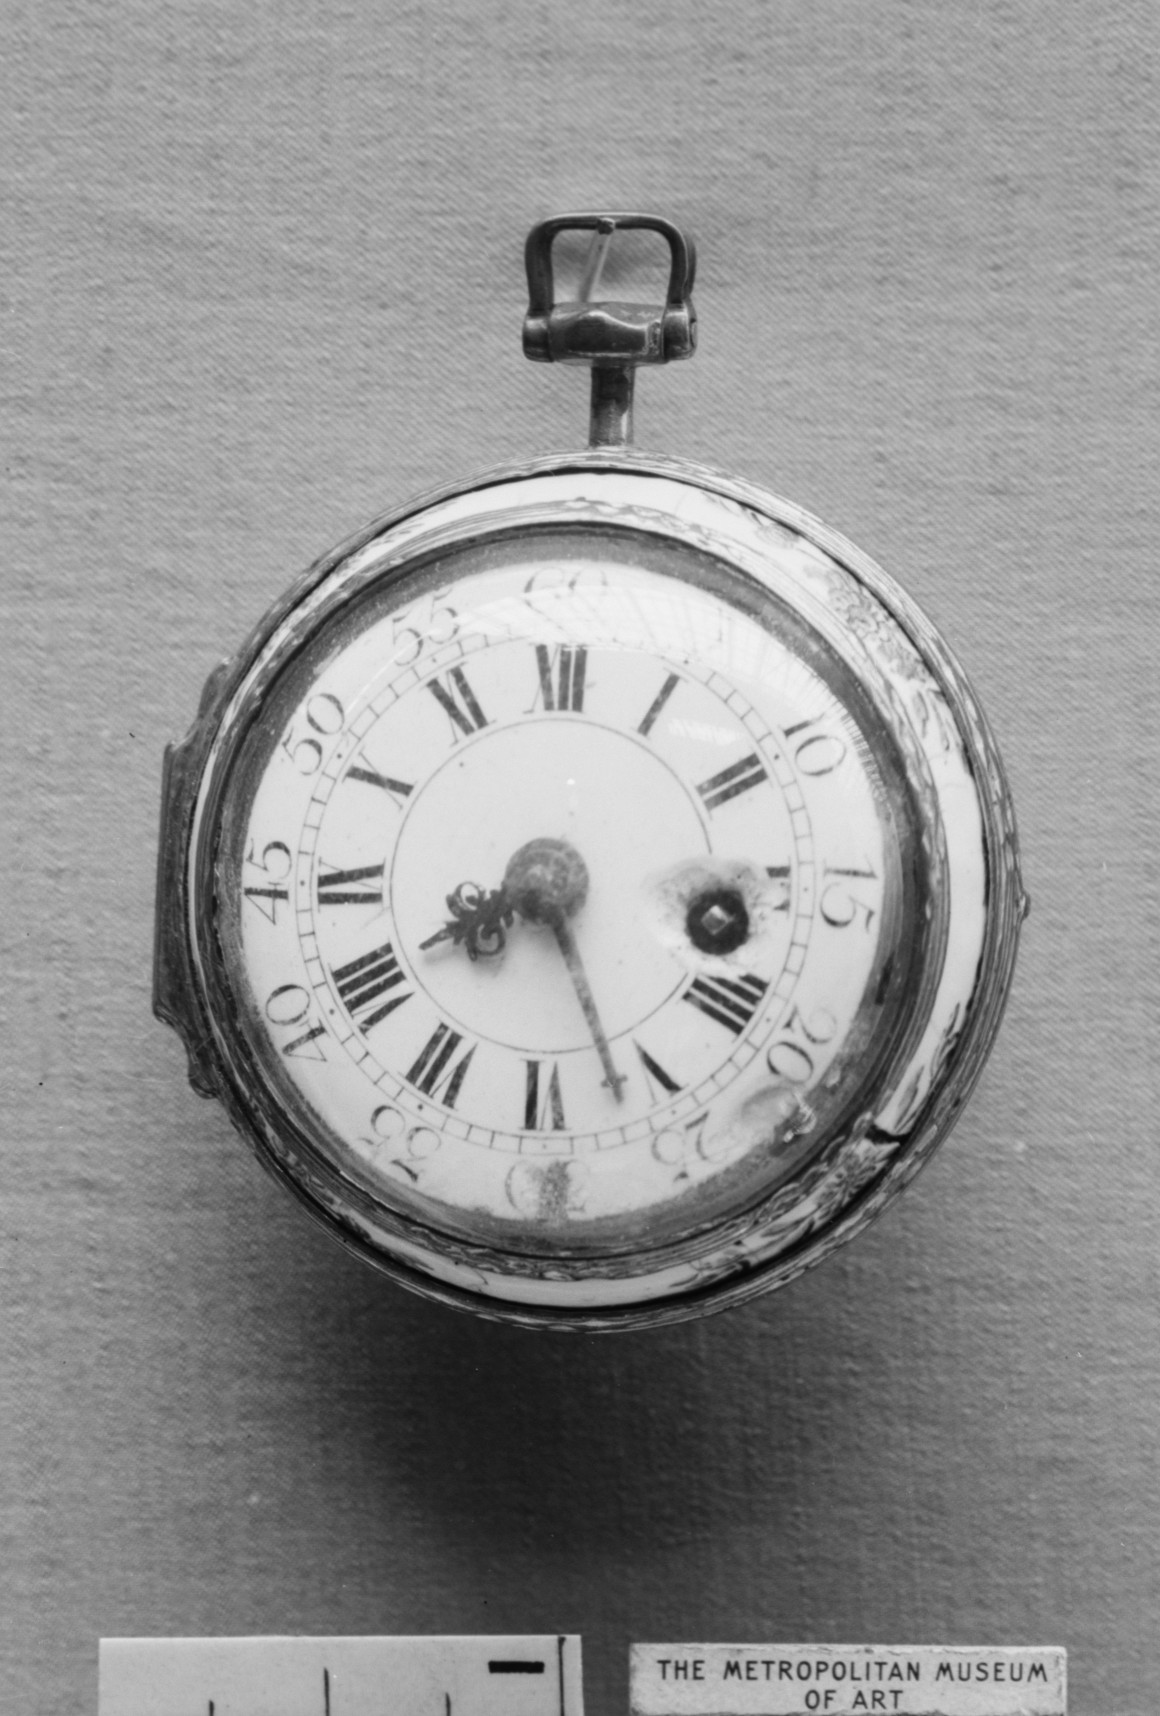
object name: watch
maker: julien le roy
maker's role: maker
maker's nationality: french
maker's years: 1686-1759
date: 1701-1800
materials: copper, enamel, gold